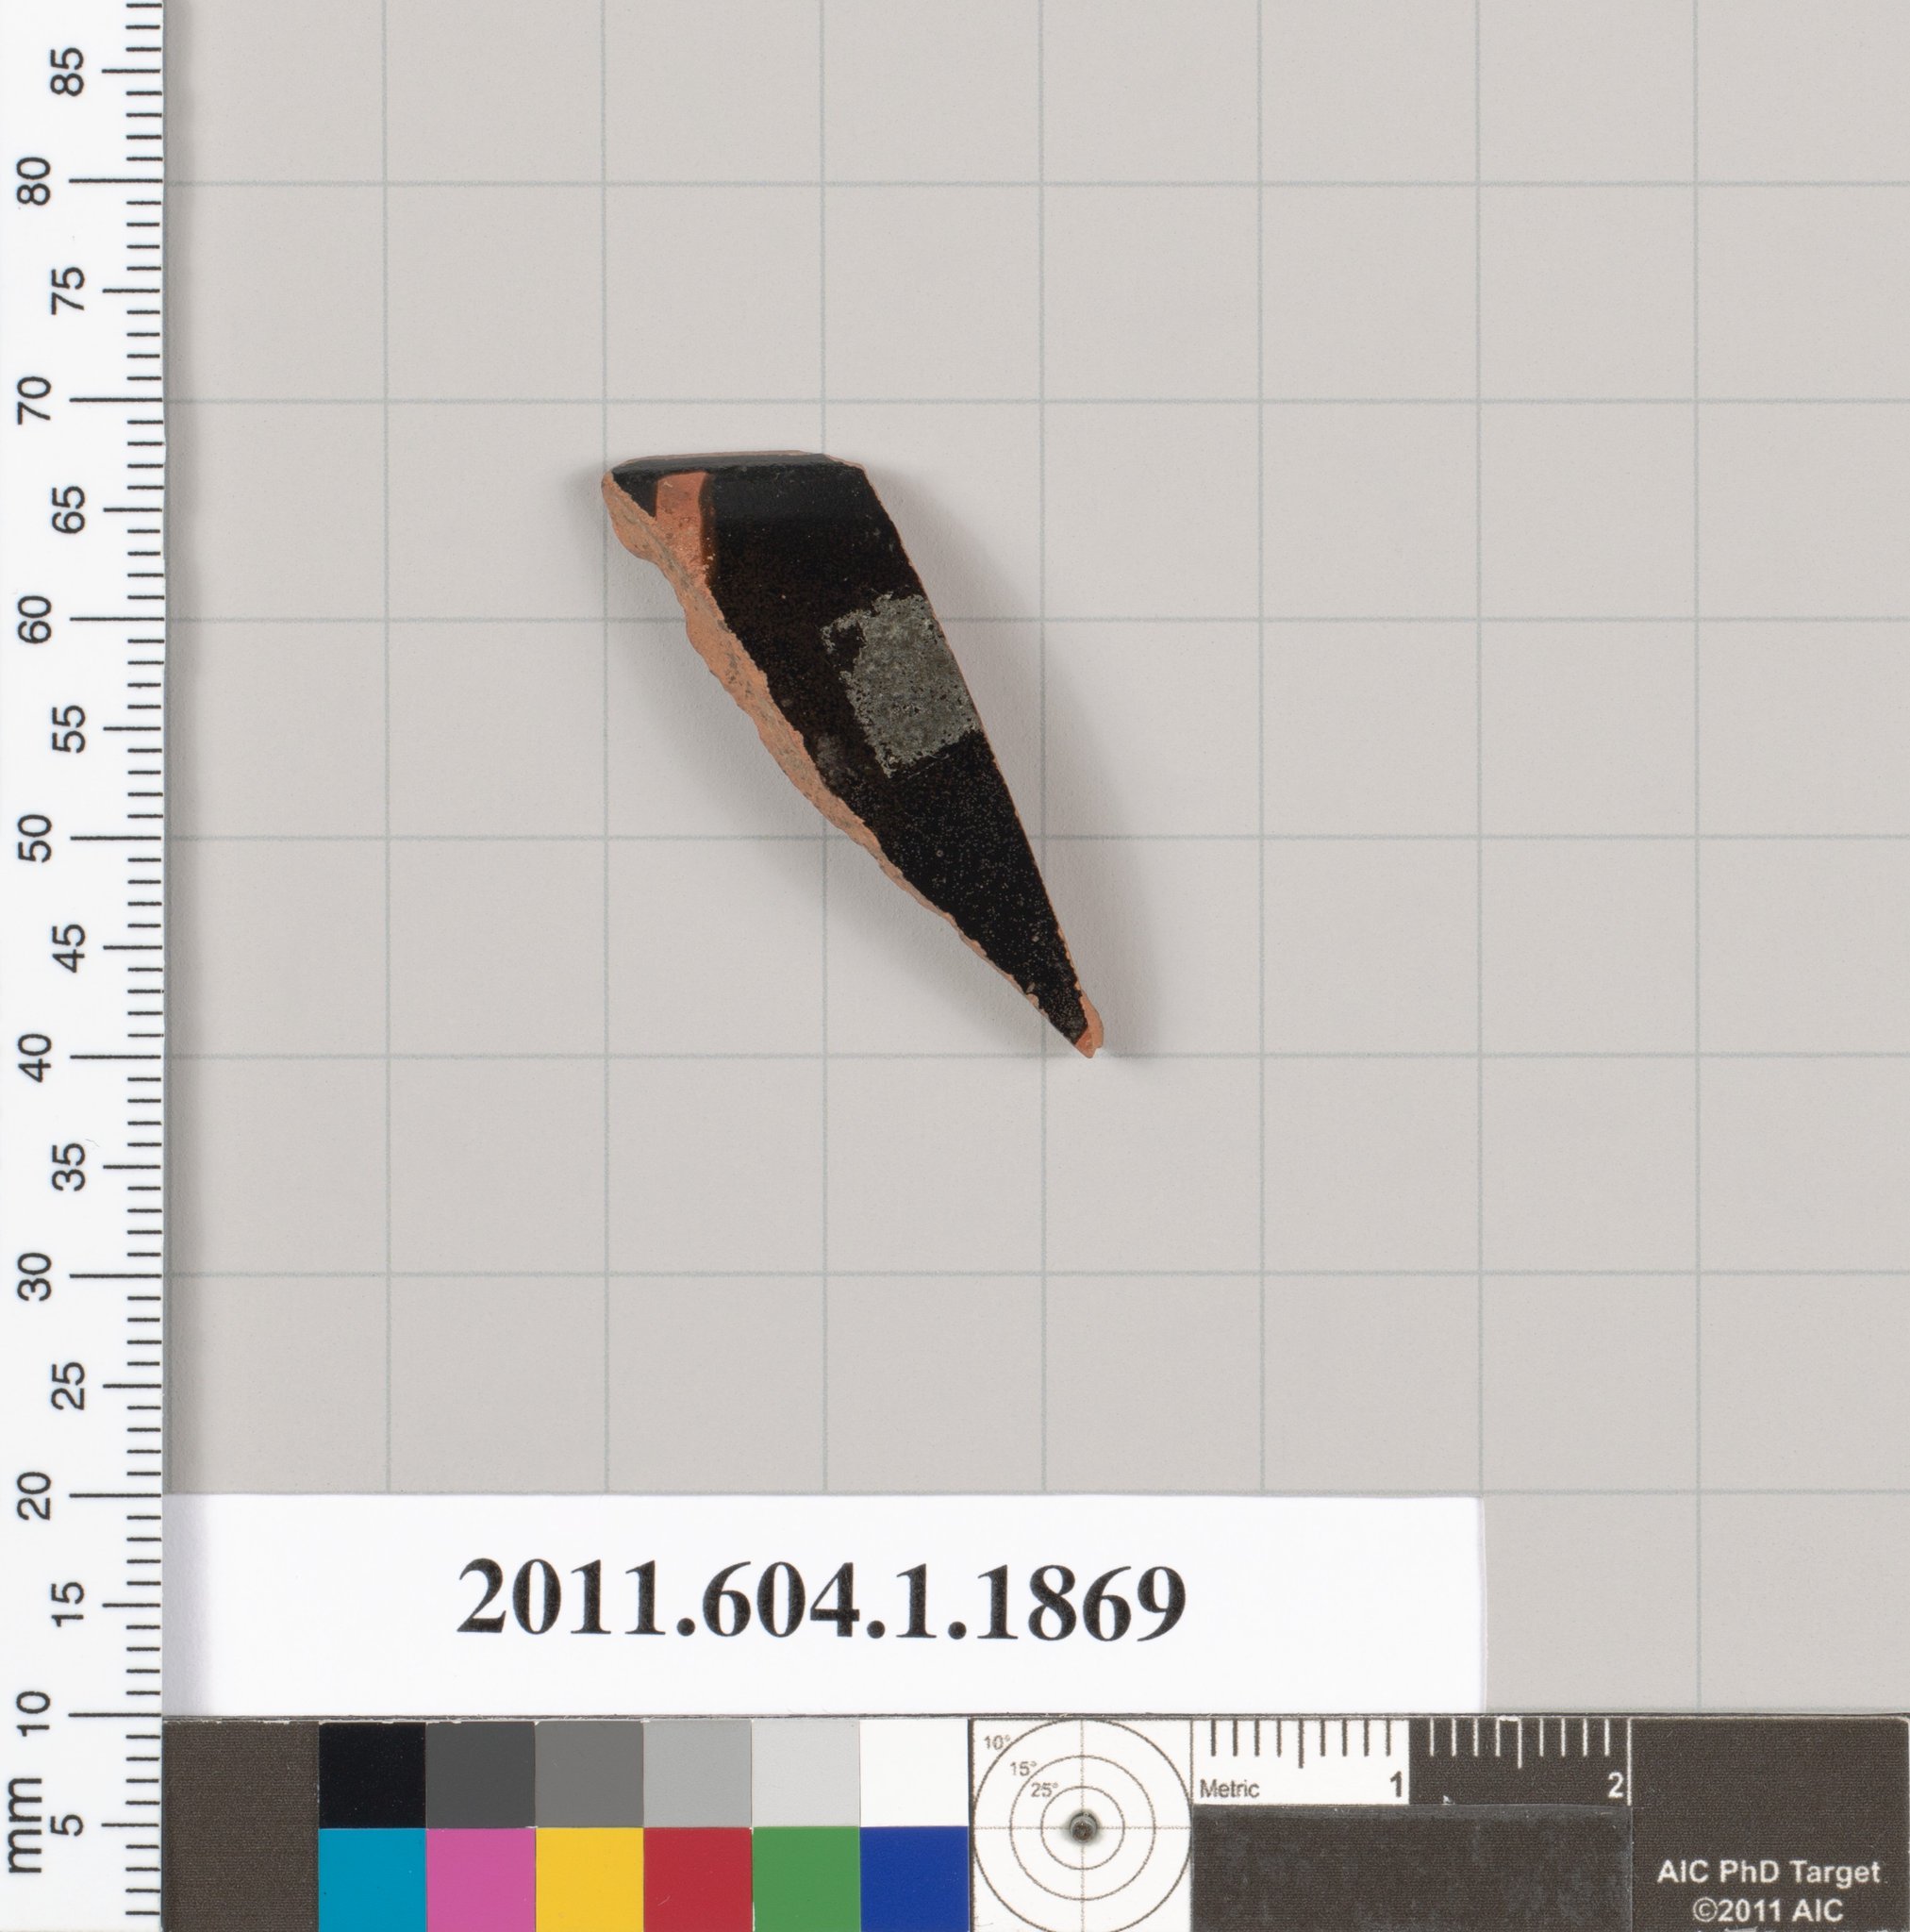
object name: kylix fragment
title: Terracotta rim fragment of a kylix (drinking cup)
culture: greek, attic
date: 475-451 BCE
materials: terracotta